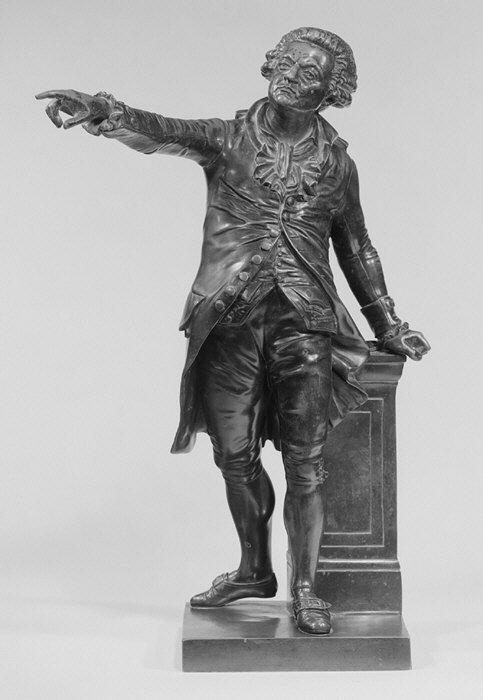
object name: statuette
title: Mirabeau Before the Convention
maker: andre-françois-joseph truphême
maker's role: artist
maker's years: 1820-1888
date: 1857-1872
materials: bronze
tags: french revolution,men,portraits